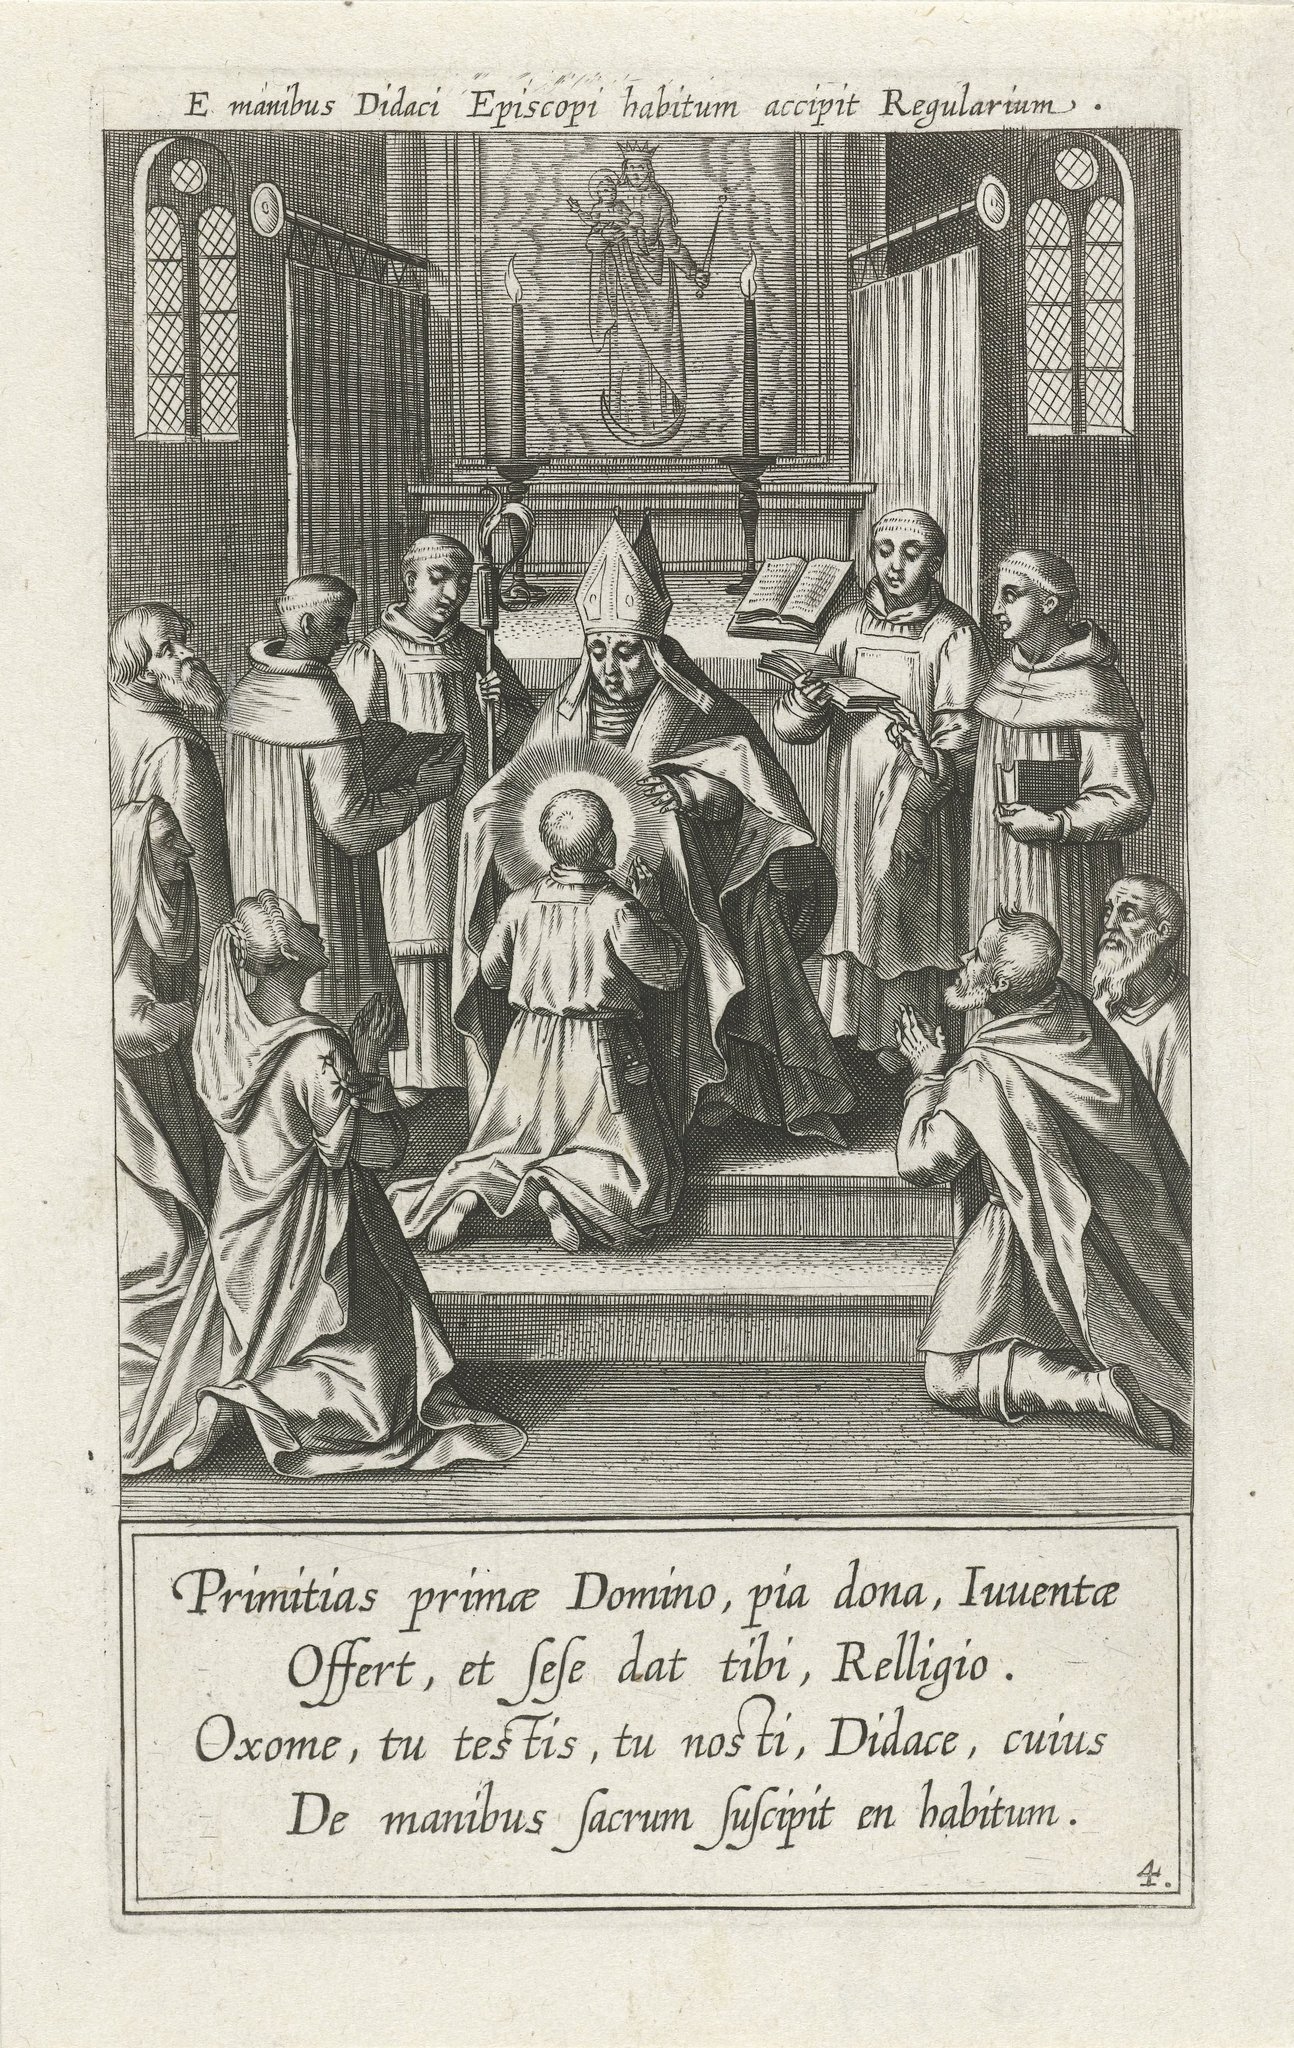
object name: book illustration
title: Vita et miracula S.P. Dominici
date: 1611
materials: paper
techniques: engraving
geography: poland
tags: personal devotion of st. dominic - baptism, consecration, taking vows of male saint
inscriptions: collector's mark: Lugt 2228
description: De heilige Dominicus wordt door de bisschop gewijd. De prent heeft een Latijns opschrift en onderschrift en maakt deel uit van een prentserie voor een boek over het leven van de heilige Dominicus.